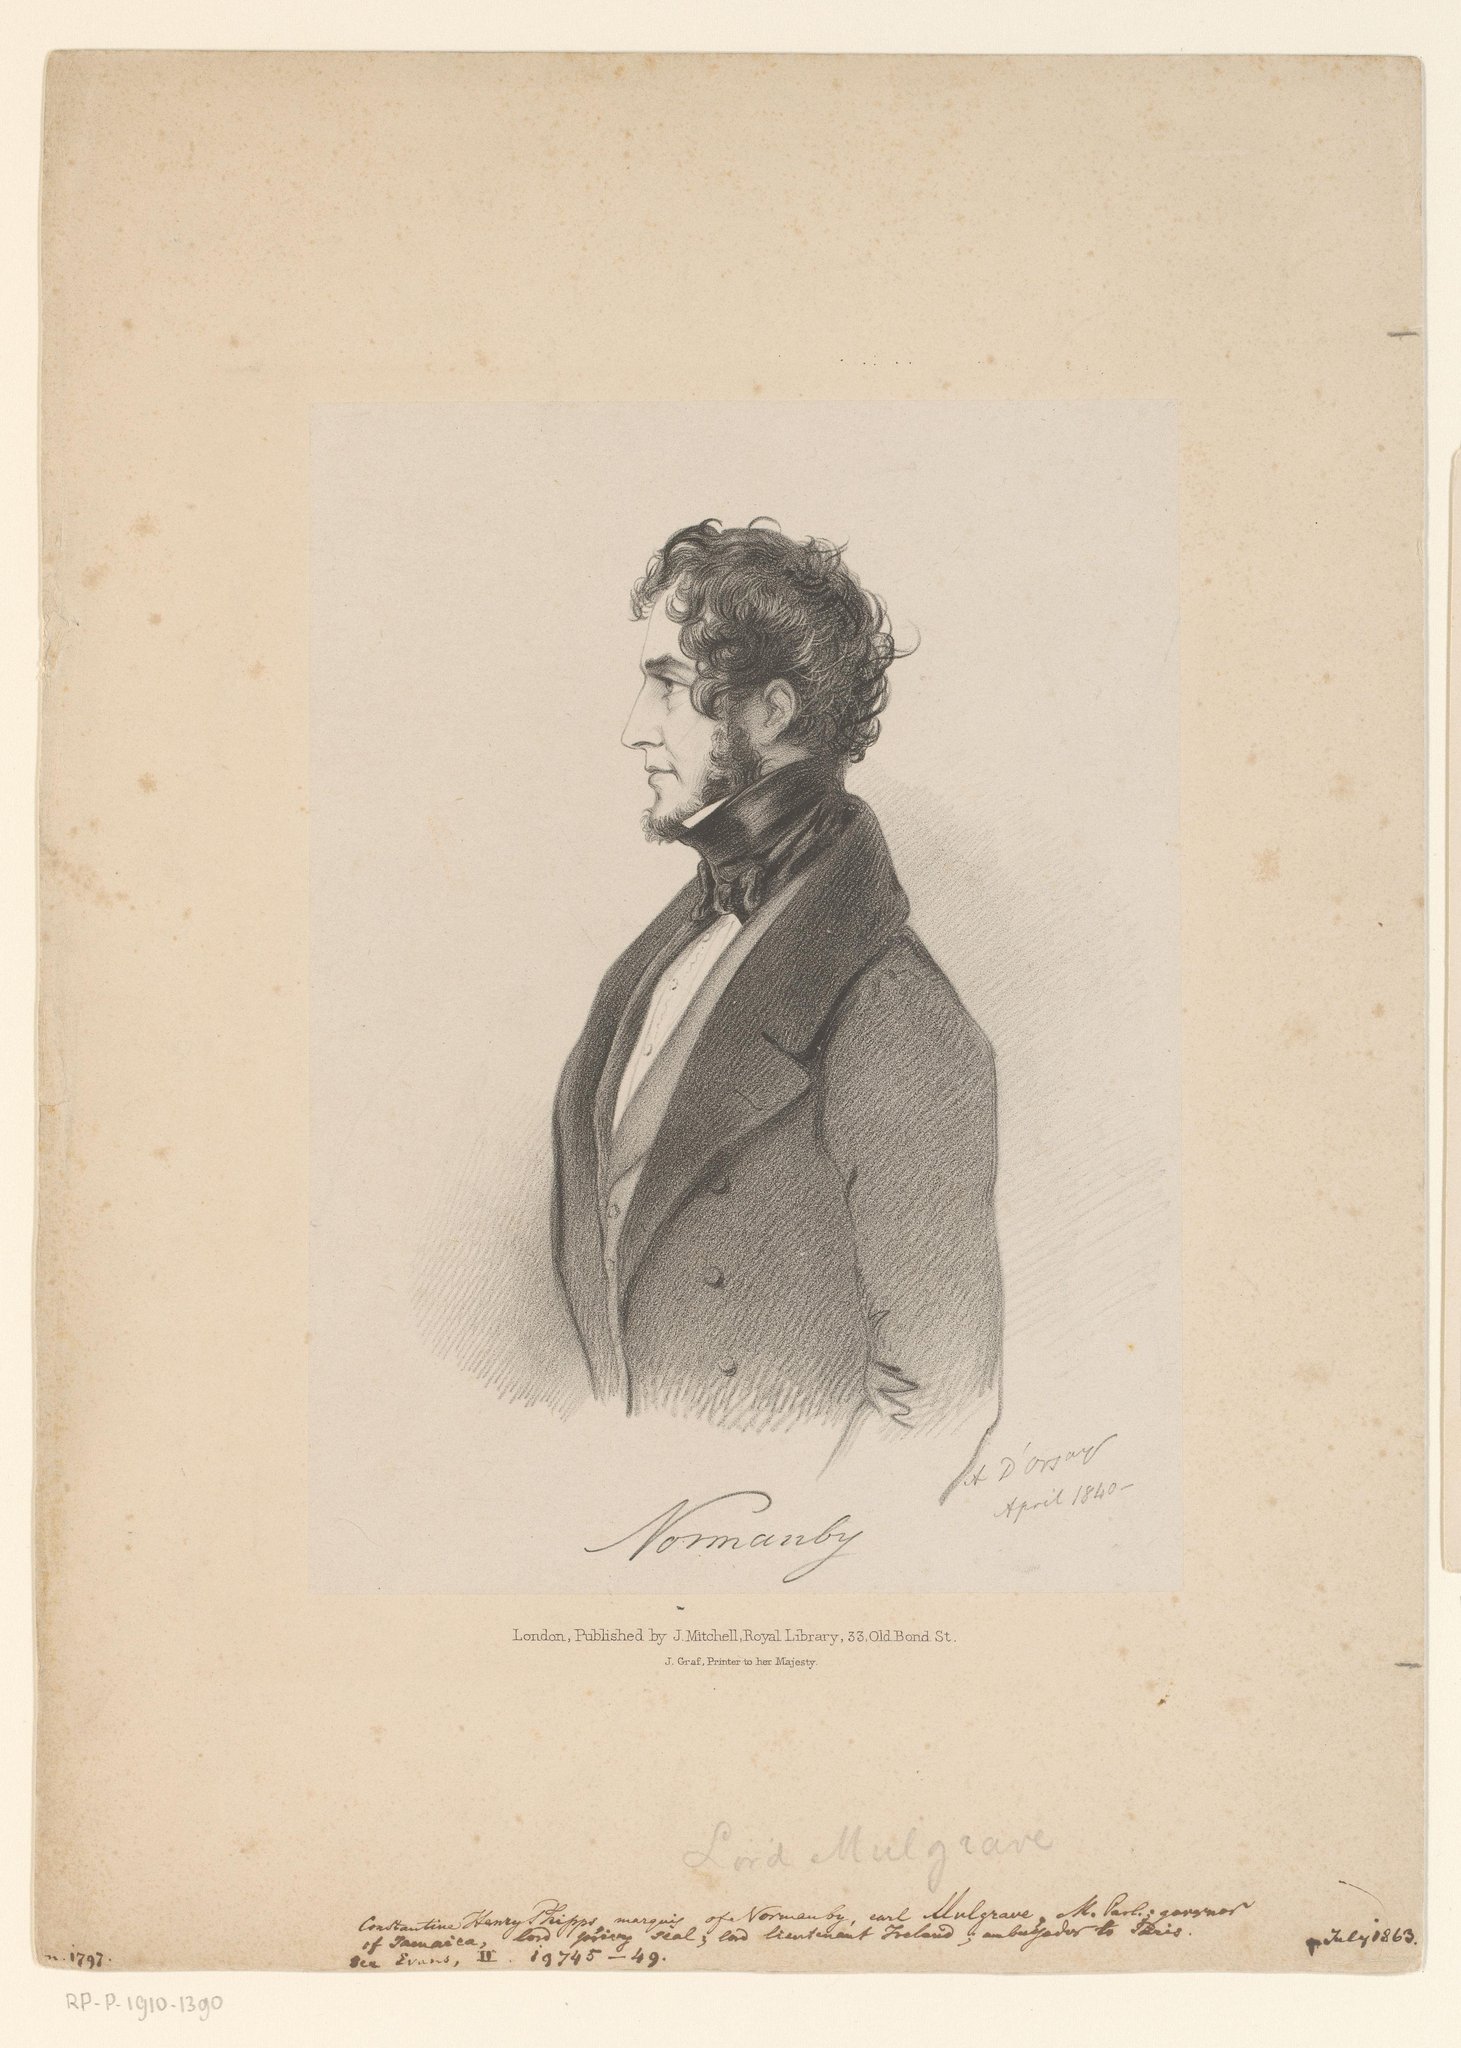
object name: print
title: Portret van Constantine Phipps, eerste markies van Normanby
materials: paper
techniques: lithograph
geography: england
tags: politician, historical persons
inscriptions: collector's mark: Lugt 2228